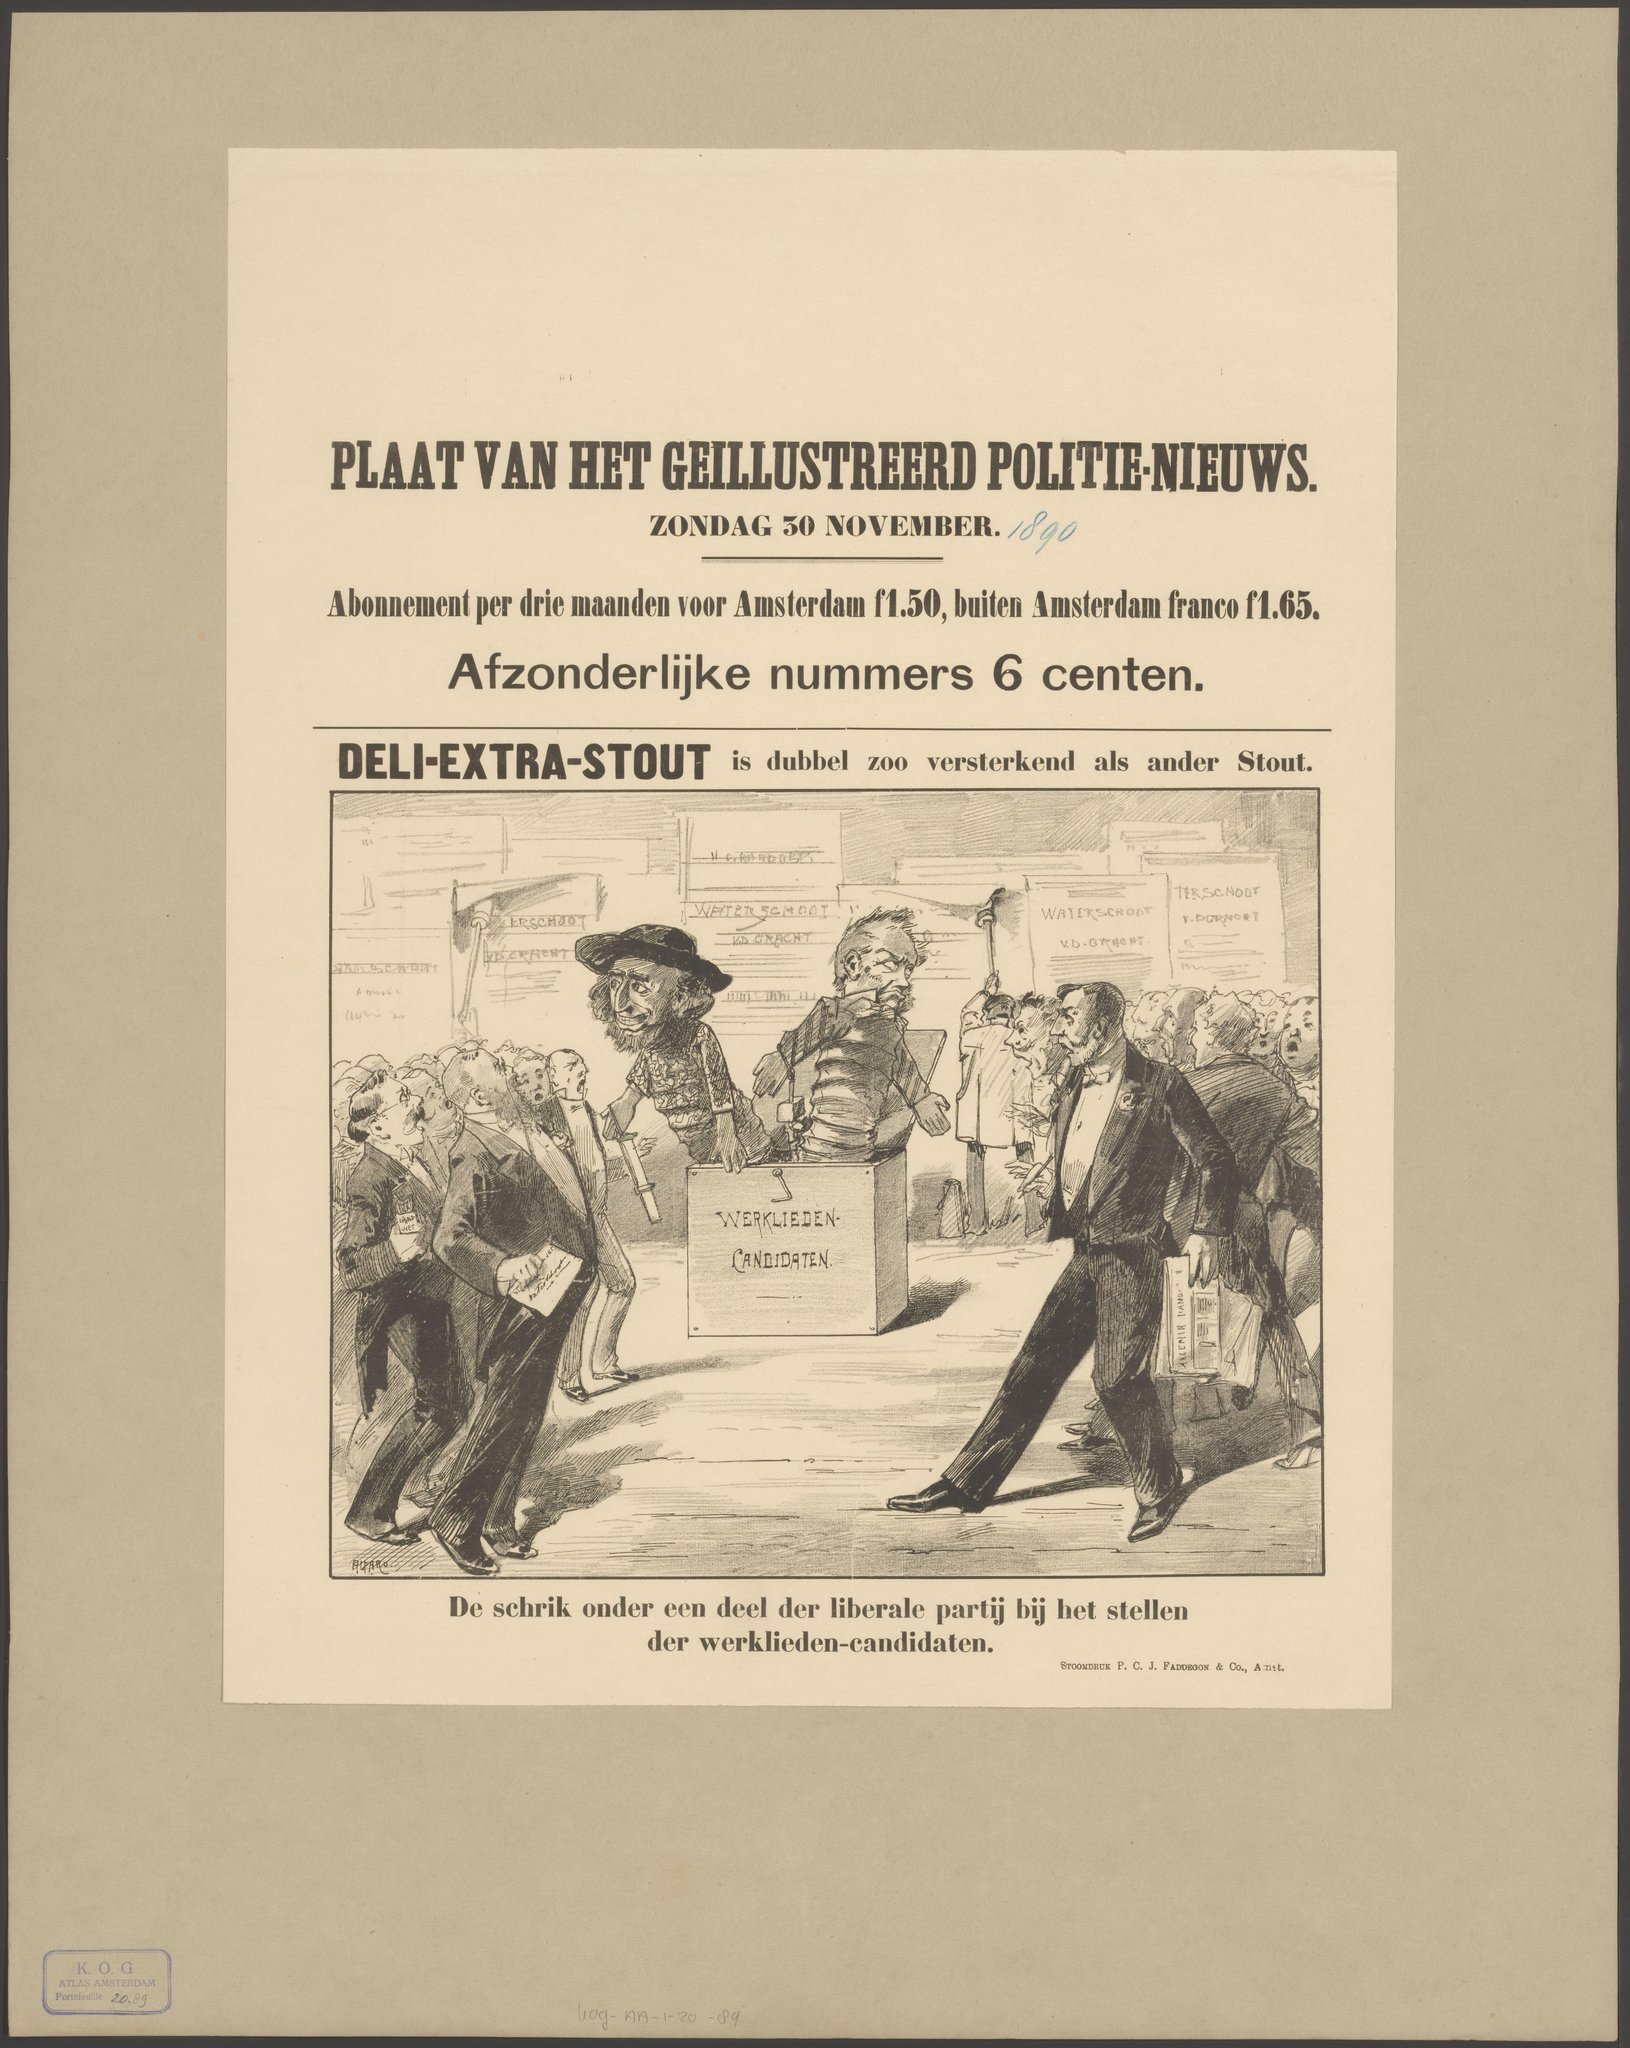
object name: cartoon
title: De schrik onder een deel der liberale partij bij het stellen der werklieden-candidaten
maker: alfaro reijding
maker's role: draughtsman, engineer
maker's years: 1863-1930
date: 1890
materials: paper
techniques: letterpress printing, lithograph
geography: amsterdam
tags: amsterdam, politician, political campaign, politician, e.g. party leader, (playing with) toys, political caricatures and satires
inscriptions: collector's mark: Lugt 1641b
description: Gepubliceerd als bijvoegsel van 'Geïllustreerd Politie-Nieuws', 30 november 1890.